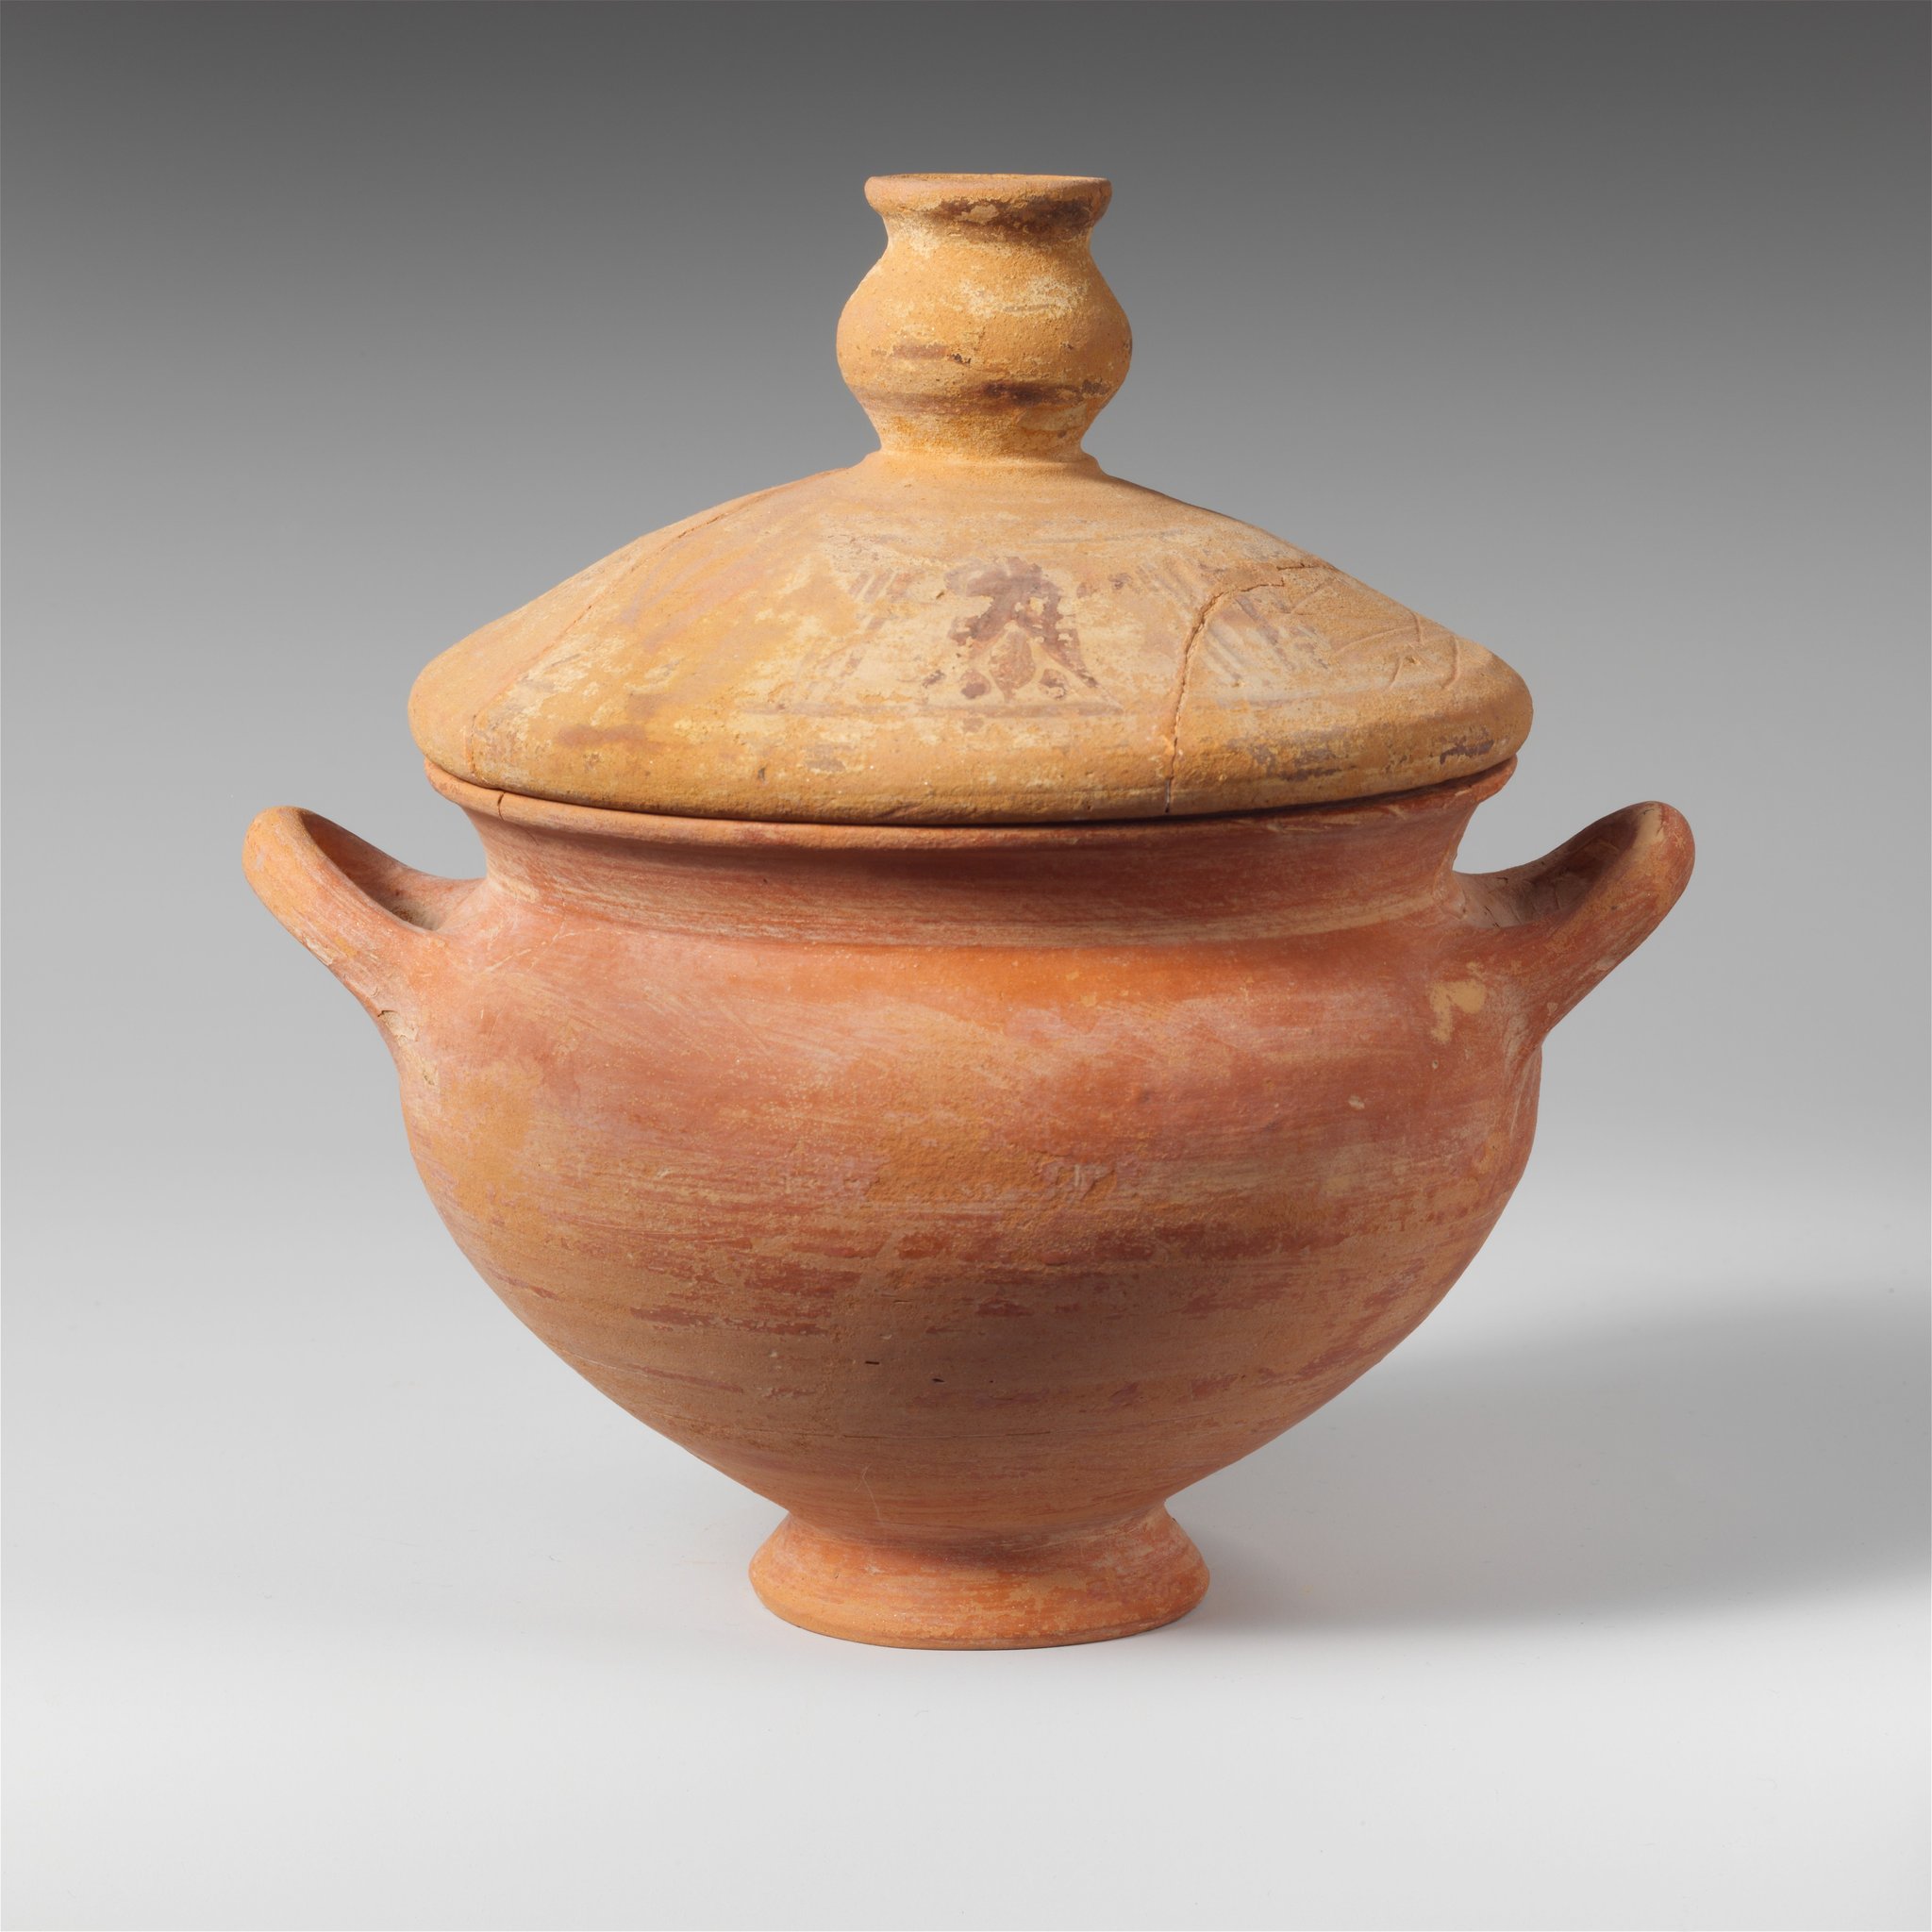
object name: skyphos with lid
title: Terracotta skyphos (deep drinking cup) with lid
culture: lydian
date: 600-501 BCE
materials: terracotta